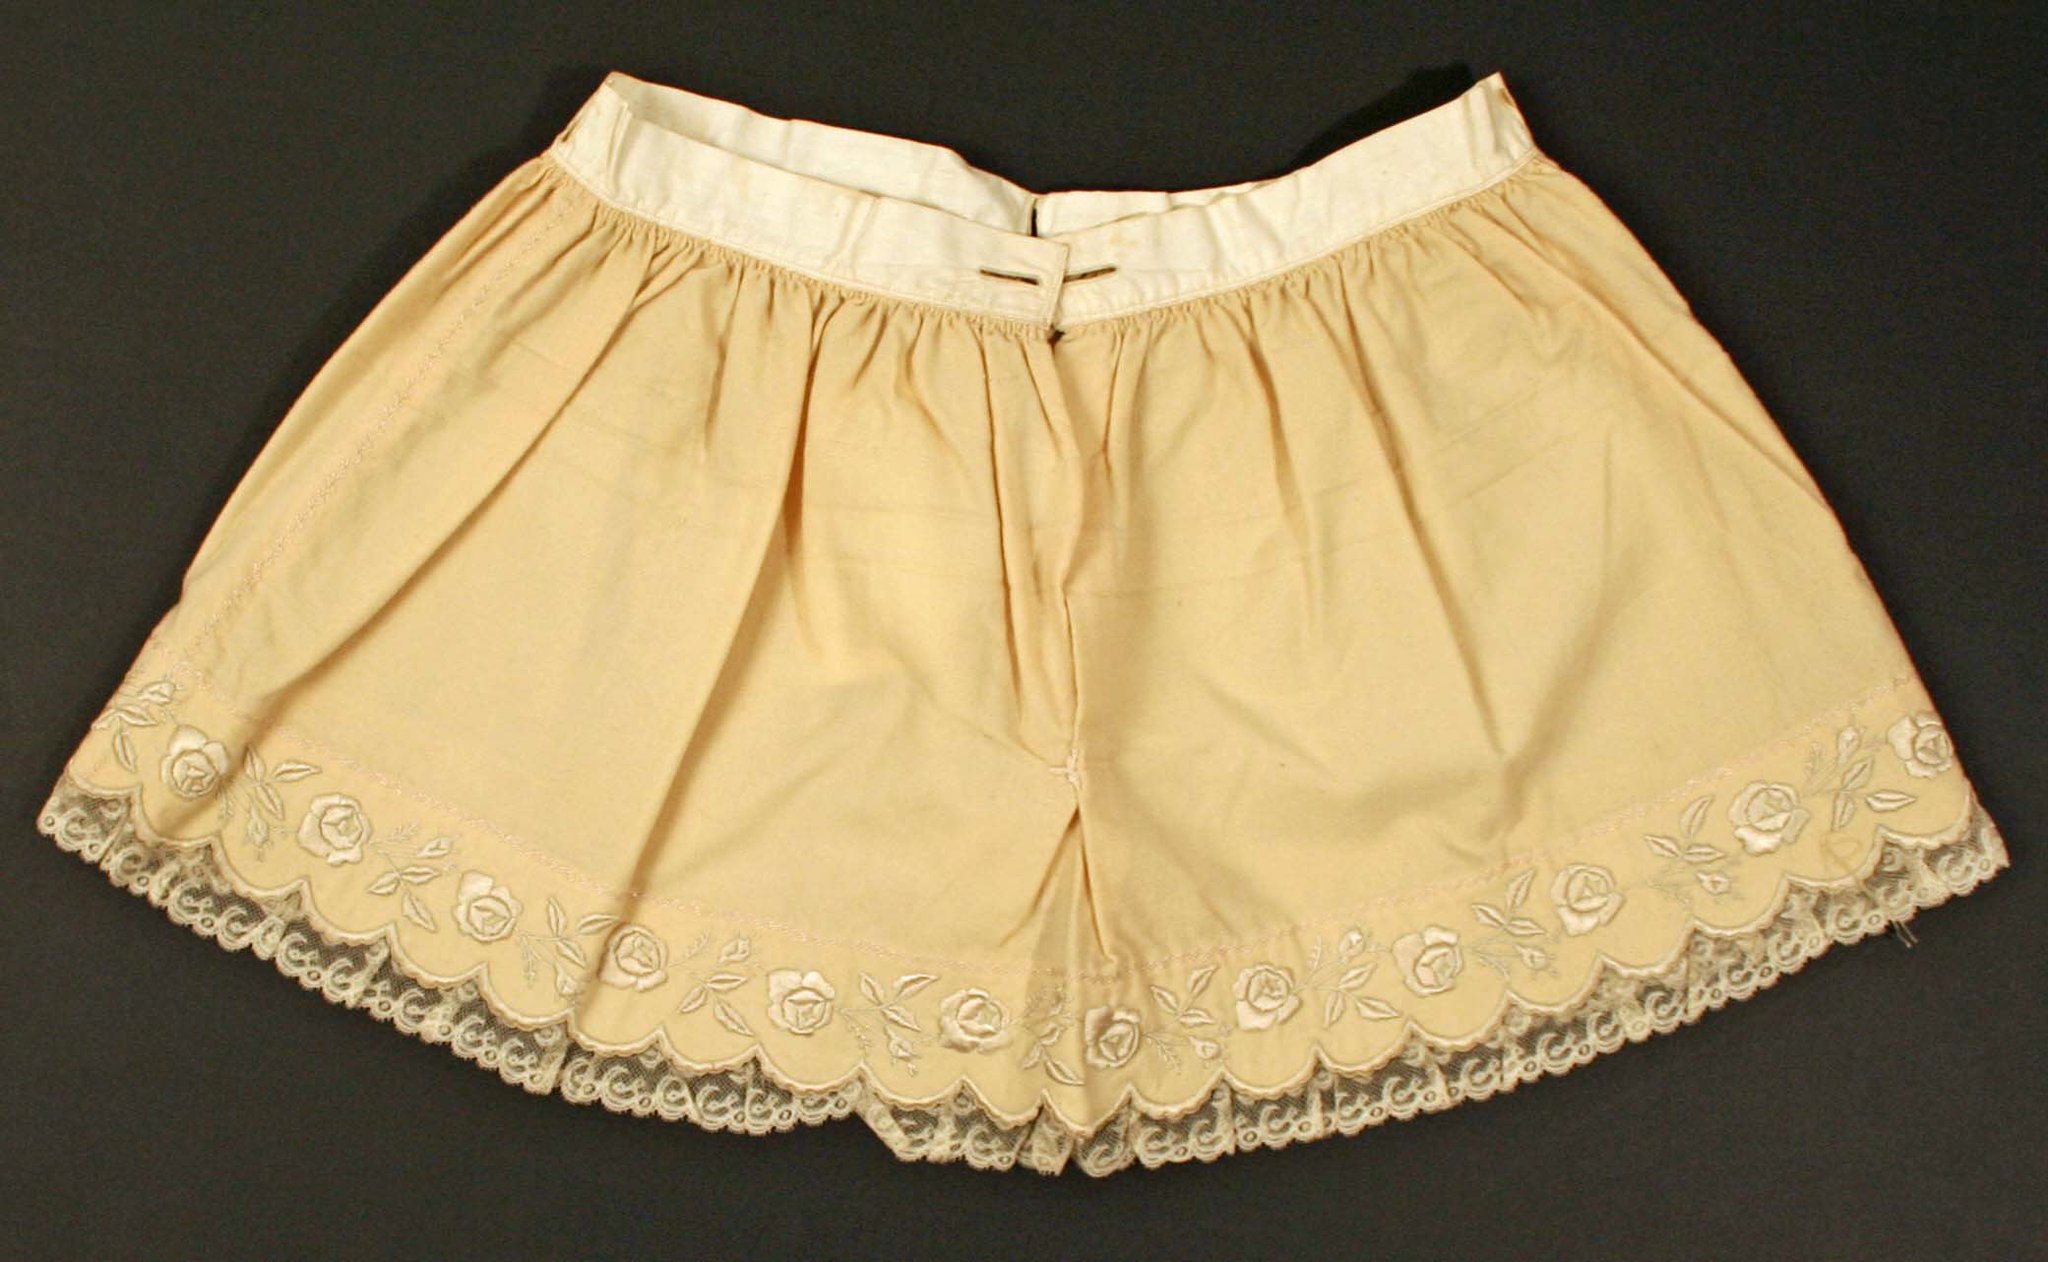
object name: underskirt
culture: american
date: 1868